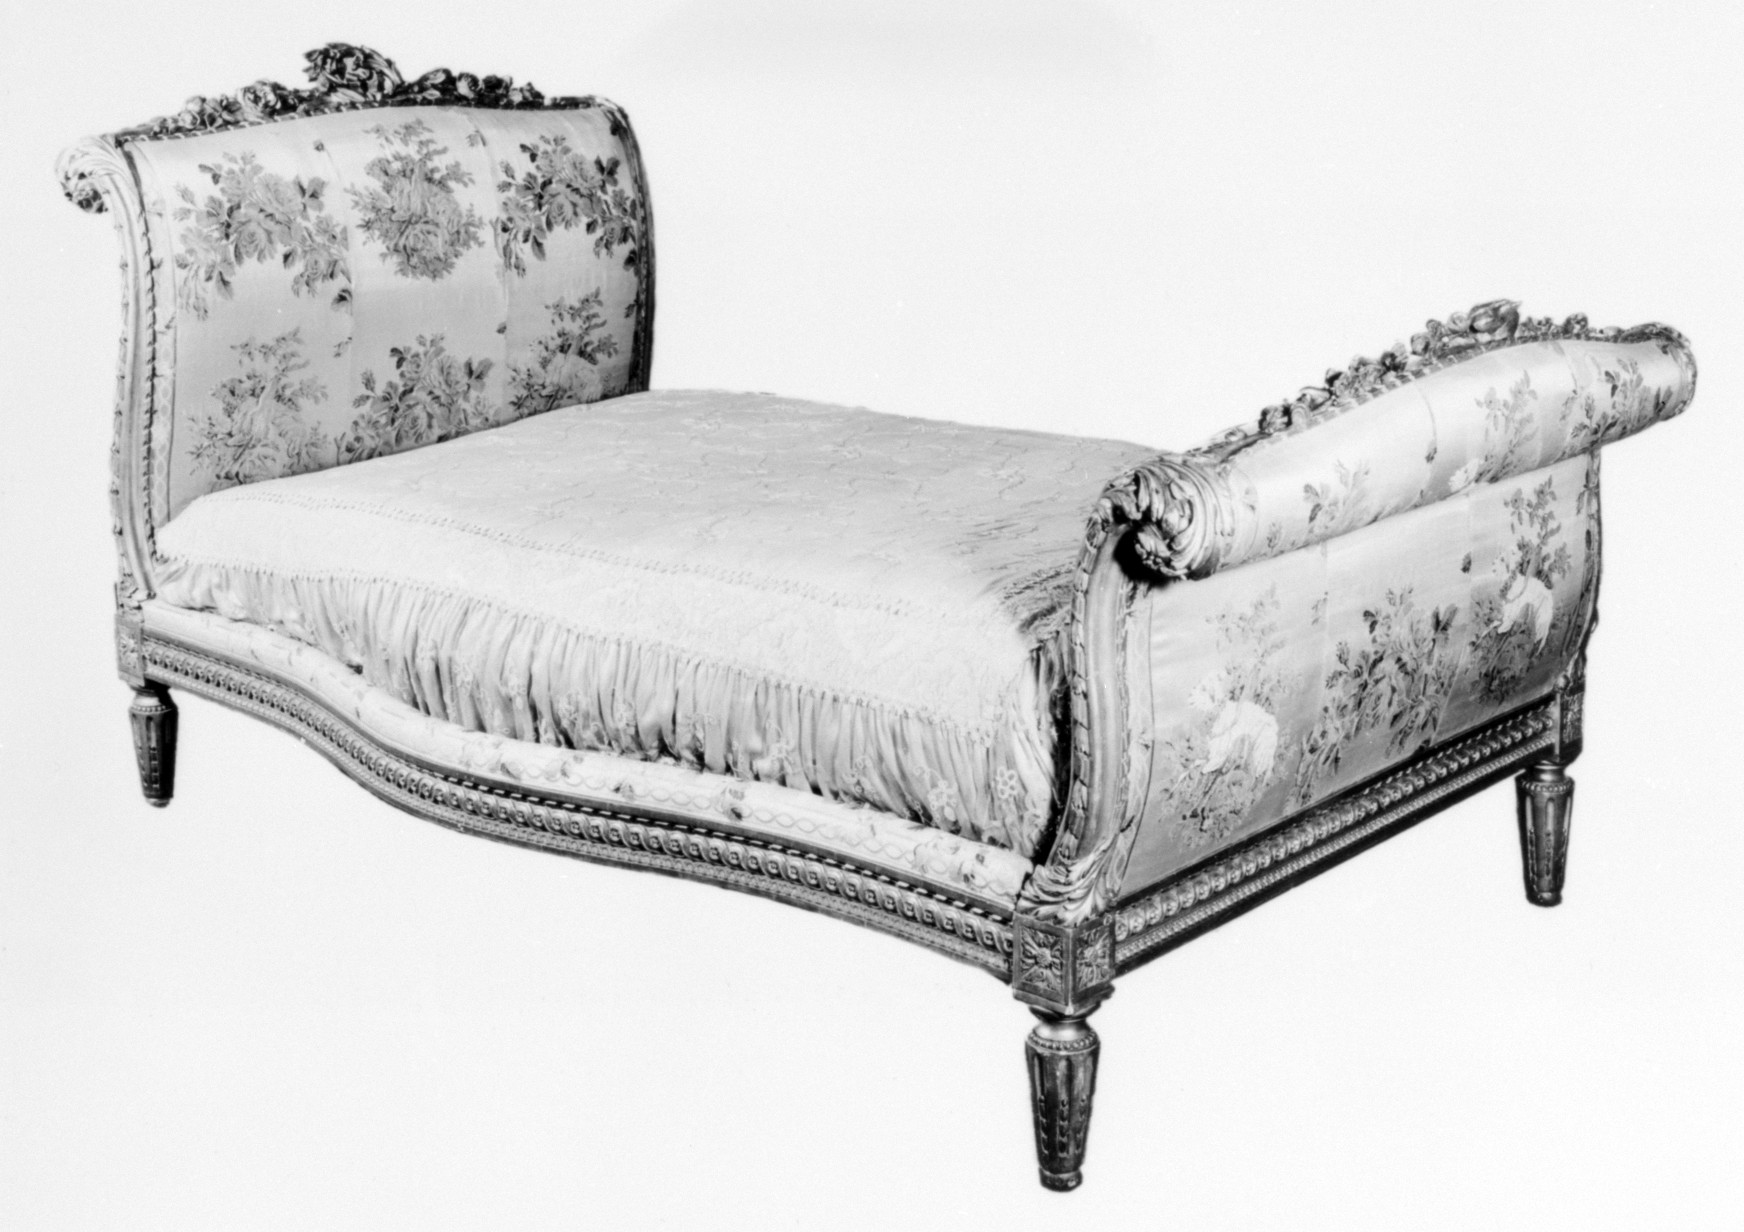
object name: bed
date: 1780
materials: silk, wood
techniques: carving, gilding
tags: beds